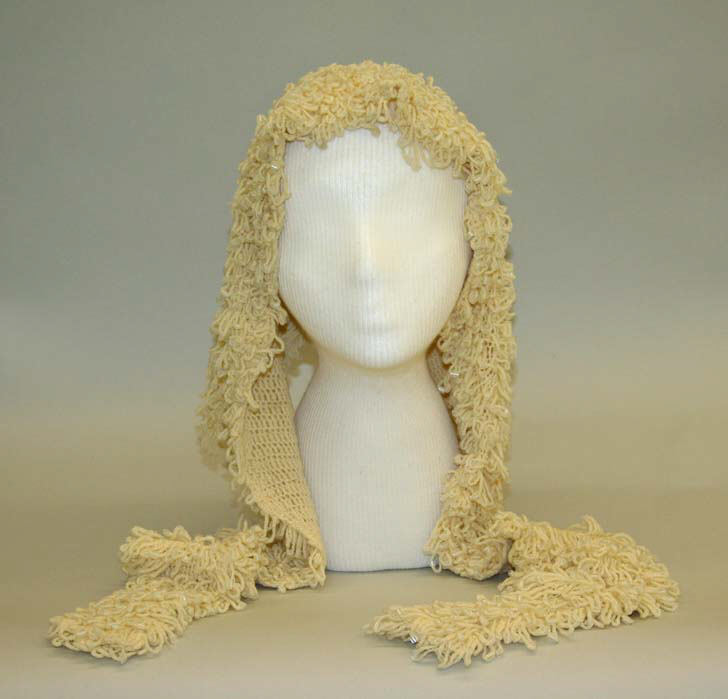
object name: fascinator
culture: american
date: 1860-1869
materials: glass, wool